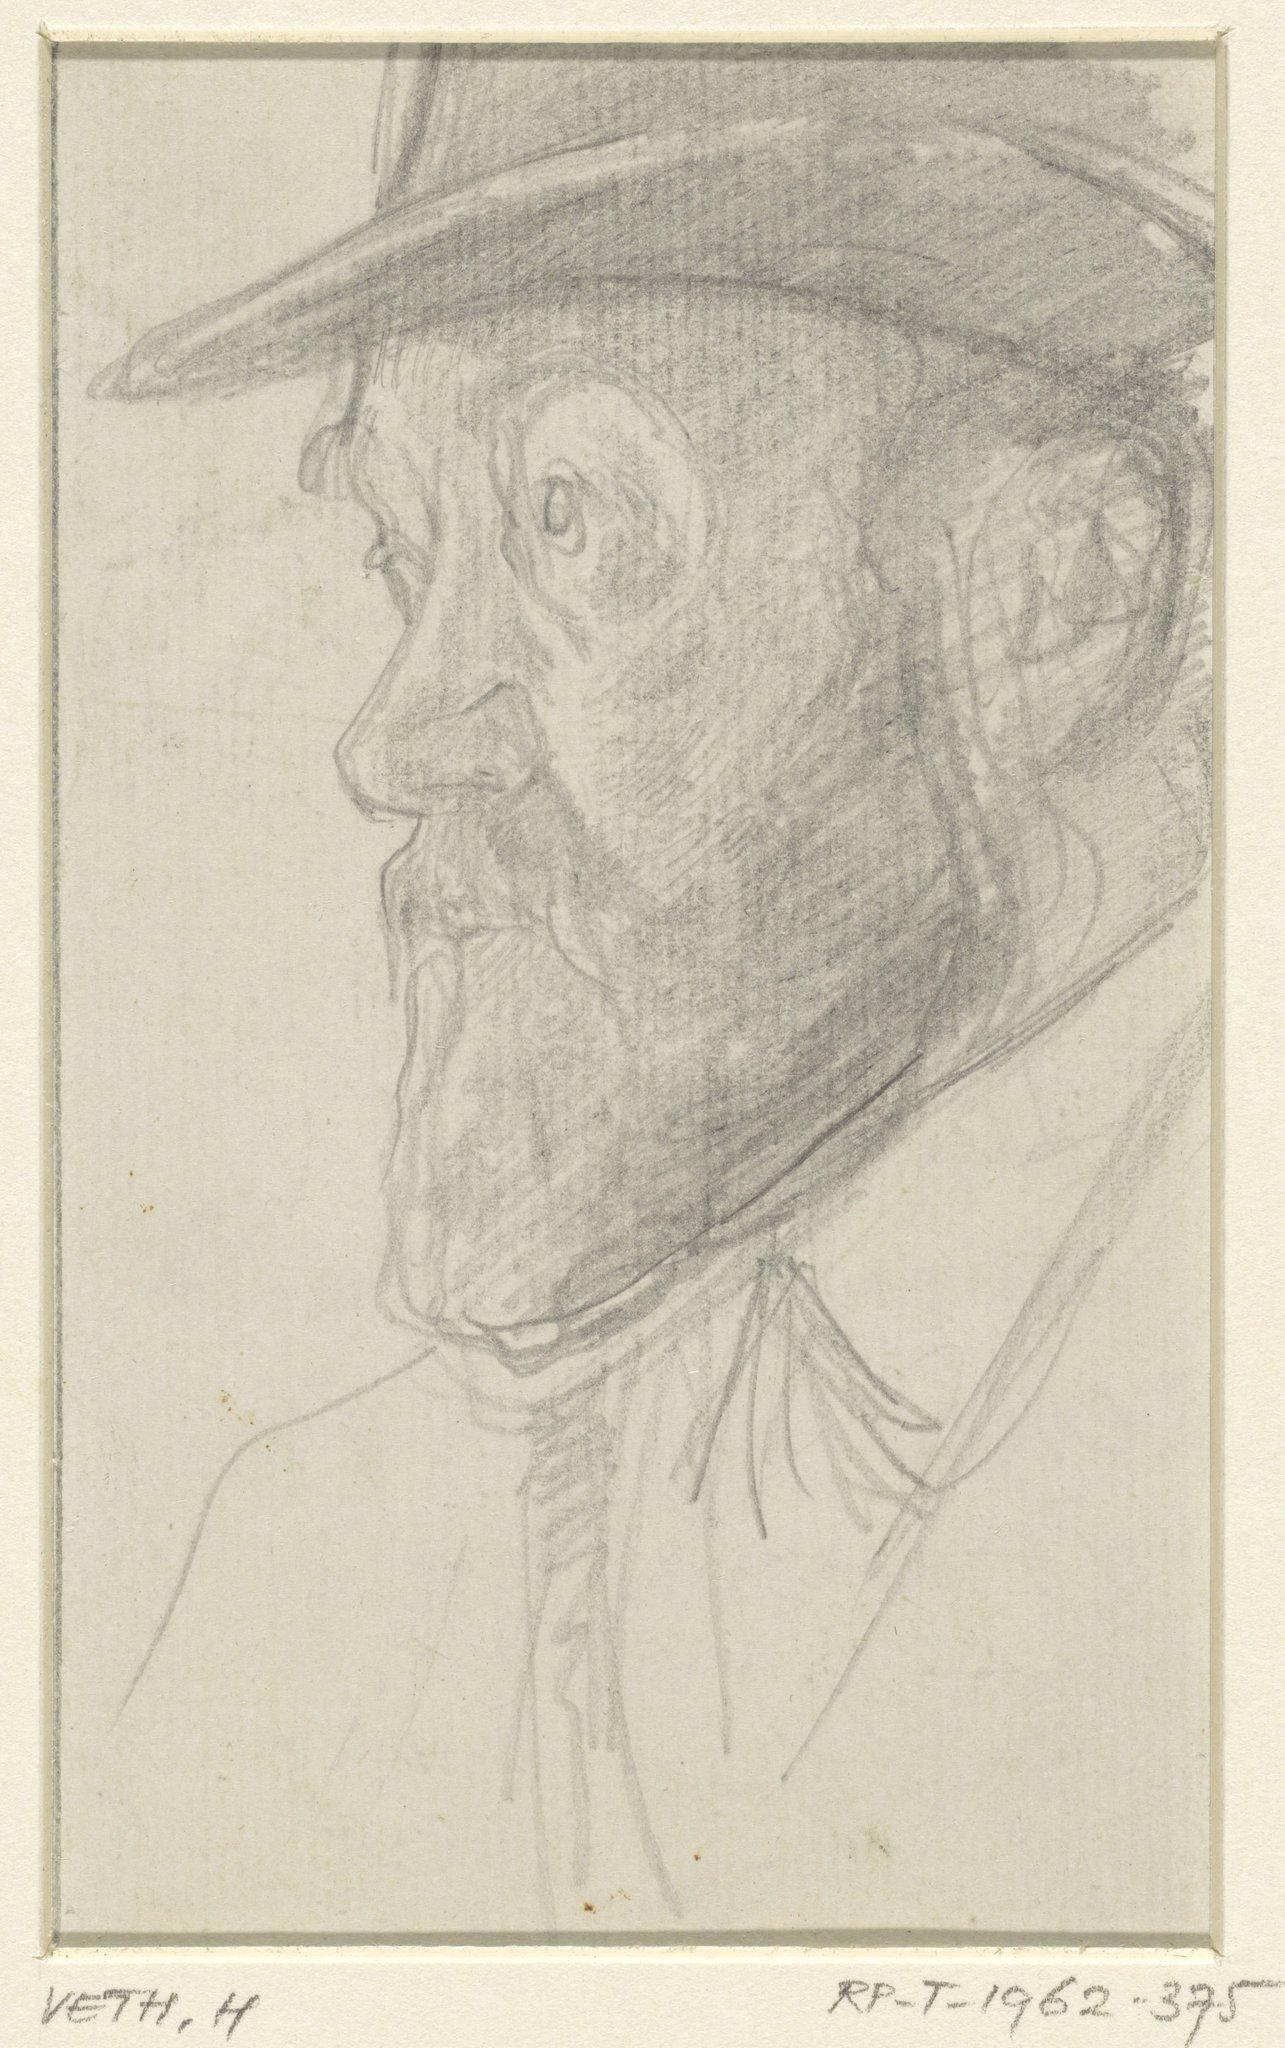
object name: drawing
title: Portret van de beeldhouwer Lambertus Zijl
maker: jan veth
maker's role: designer, draughtsman, painter, print maker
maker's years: 1864-1925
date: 1874-1925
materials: paper, pencil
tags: draughtsman, designer, lambertus zijl, portrait, self-portrait of sculptor, historical persons, portrait, self-portrait of artist